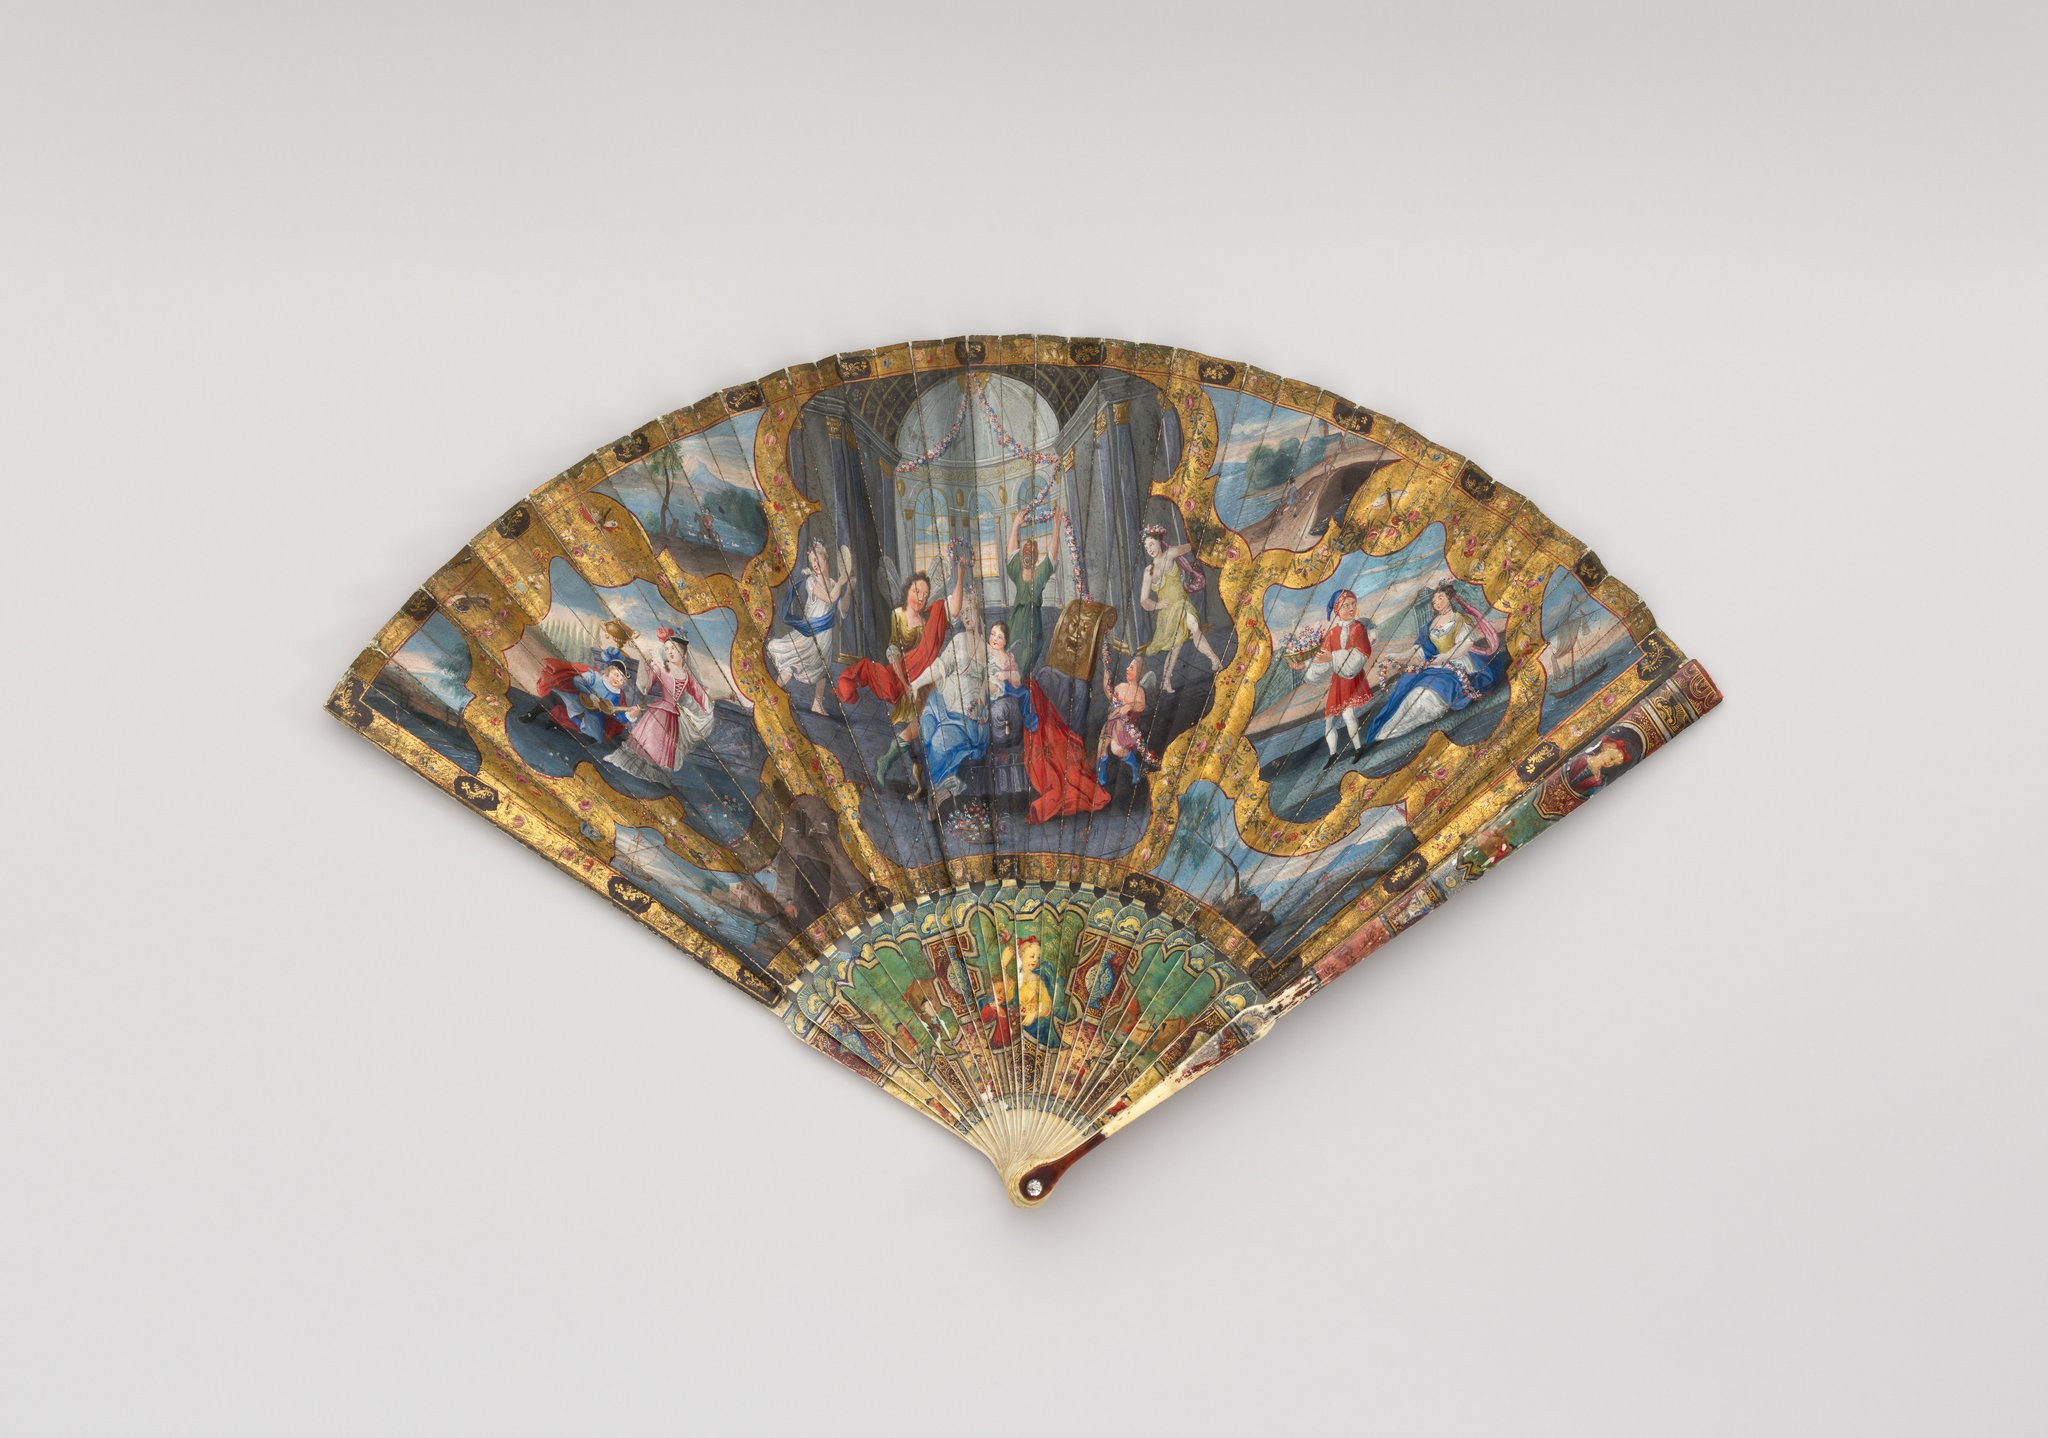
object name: fan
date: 1667-1733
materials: ivory, paper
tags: men,women